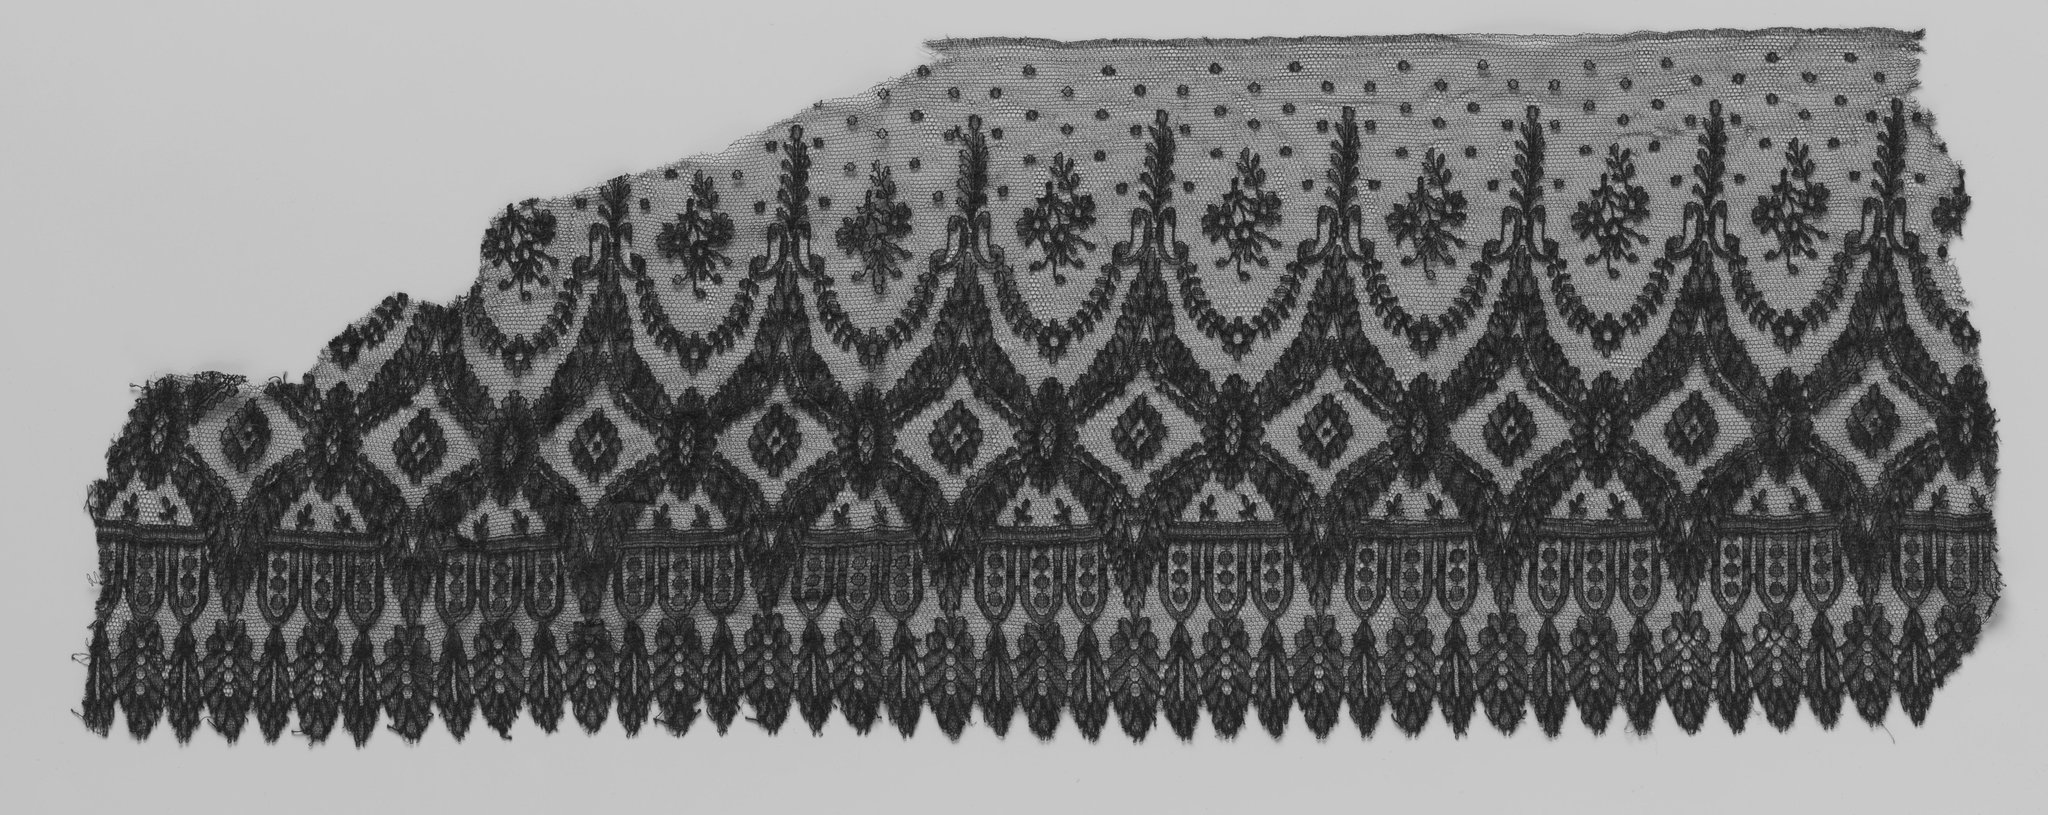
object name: strip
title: Strook zwarte machinale kant met ruitvormige cartouches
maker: Anonymous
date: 1880-1899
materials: cotton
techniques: lace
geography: calais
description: Strook zwarte machinale kant: machinale Chantilly-kant. Het zich herhalende en vrijwel symmetrische patroon bestaat iets onder de middenlijn van de strook uit een aaneenschakeling van ruitvormige cartouches. Elke ruit wordt bekroond door een smal veervormig blad op van elkaar afgewende c-voluten. Tussen de ruiten hangt een bladslinger met één rozetbloem en een losse rozentak daarboven en moesjes. Onderaan loopt achter de ruiten langs een rechte horizontale baan. Aan deze baan hangen tussen de opeenvolgende ruiten drie langerekte halve ovalen met stippen erin. Aan elke halve ovaal hangt een recht naar beneden hangend veervormig blad of korenaar, afwisselend met en zonder ronde uitsparingen in het midden. De motieven zijn met elkaar verbonden door een machinale tulegrond. De schulpenrand bestaat uit smalle diepe schulpjes en worden gevormd door de hangende korenaren. De bovenzijde van de strook is recht afgewerkt, maar aan de rechterkant is vanaf de bovenzijde een schuin stuk van de strook afgeknipt.